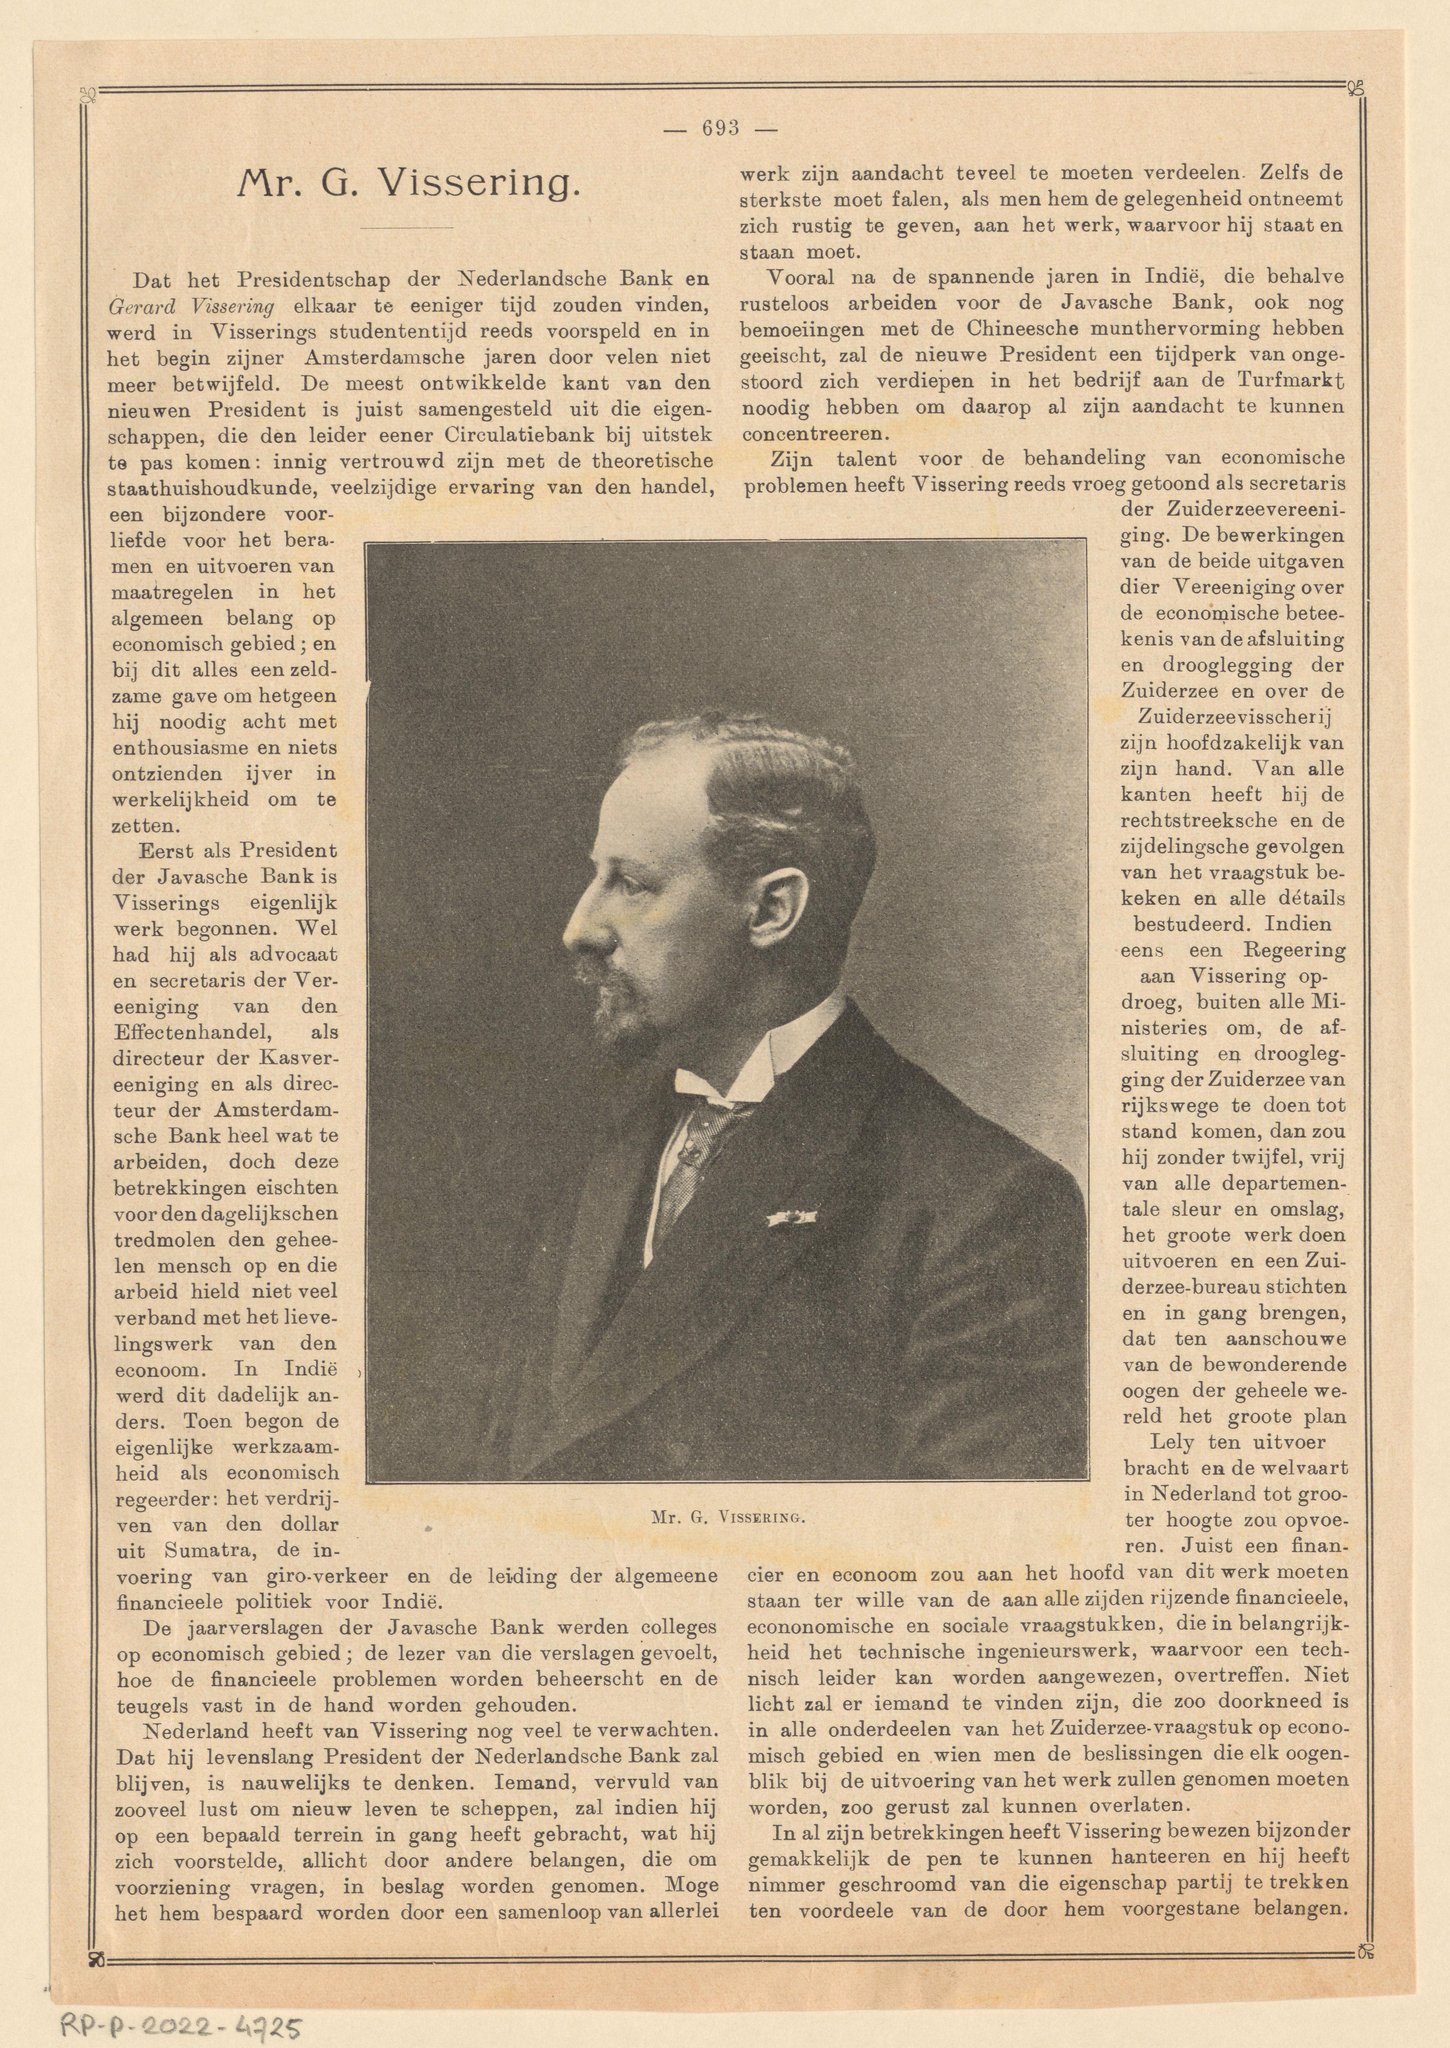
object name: photomechanical print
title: Portret van Gerard Vissering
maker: Anonymous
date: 1912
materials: paper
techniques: letterpress printing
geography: netherlands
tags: designer, gerard vissering, banker, historical persons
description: Fotomechanische afdruk uit: Eigen Haard (1912), p. 693.